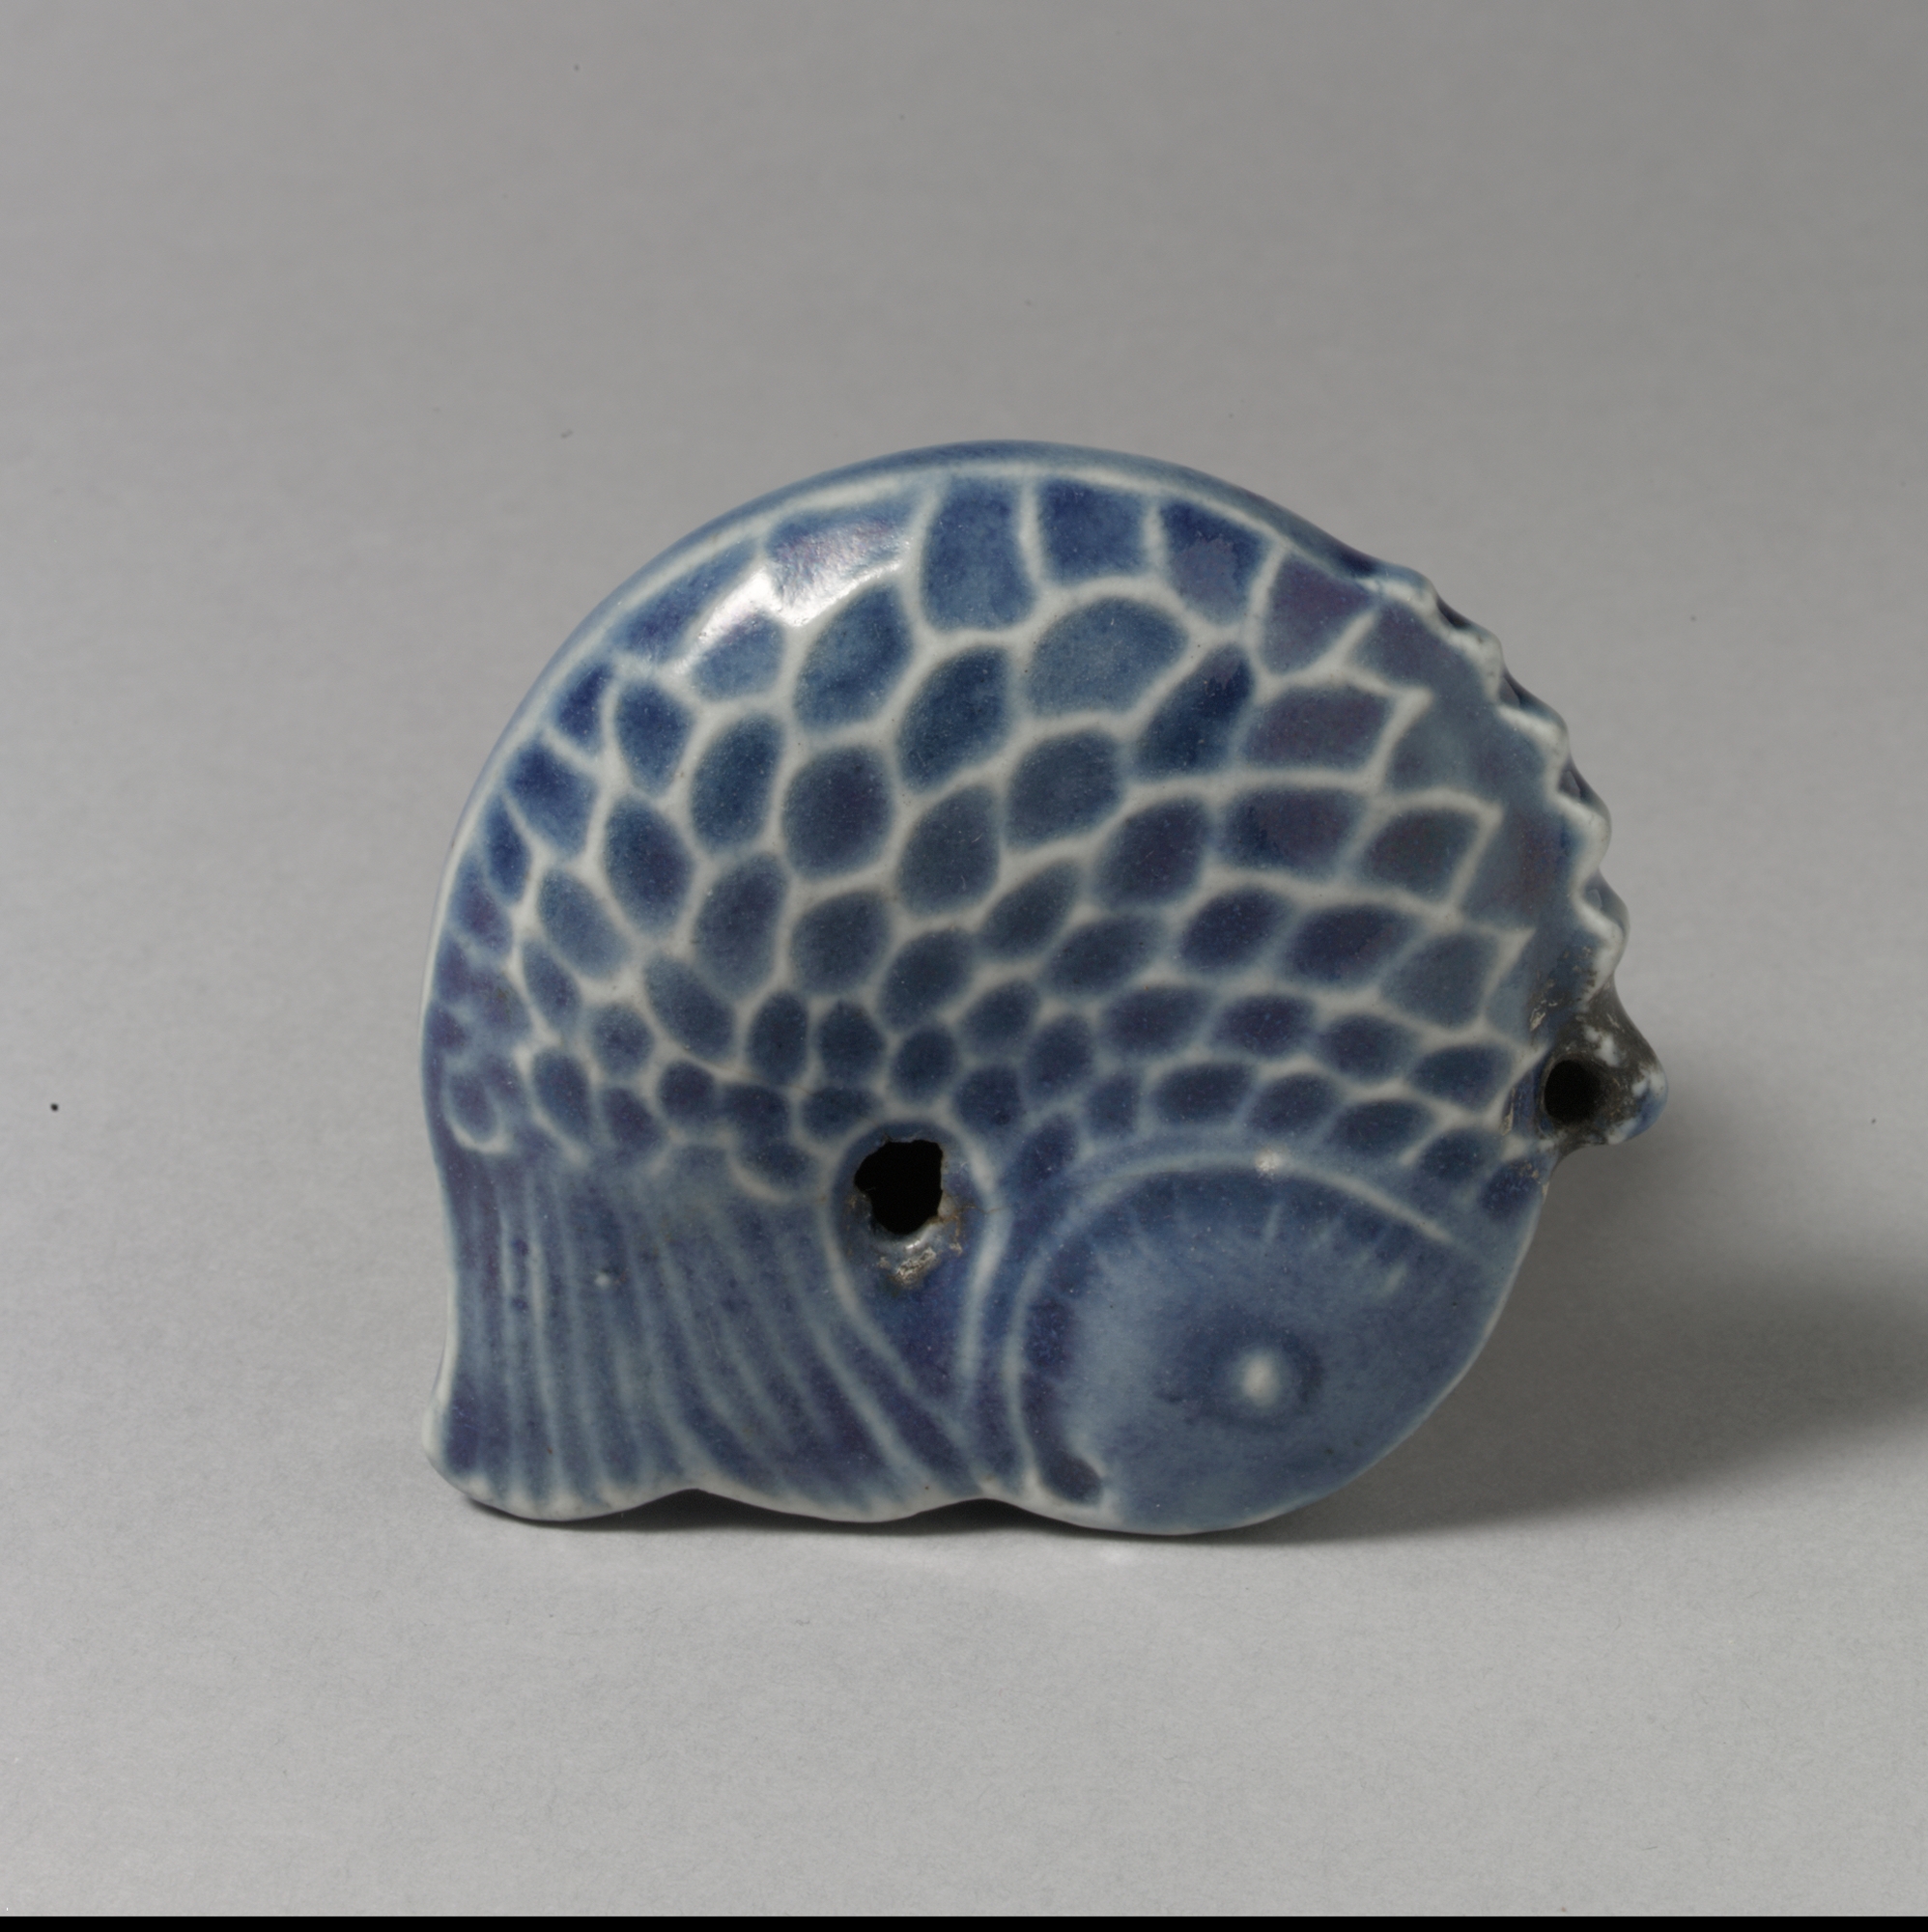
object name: water dropper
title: Water dropper in the shape of a fish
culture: korean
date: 1867-1900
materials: cobalt, porcelain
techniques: underglaze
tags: fish